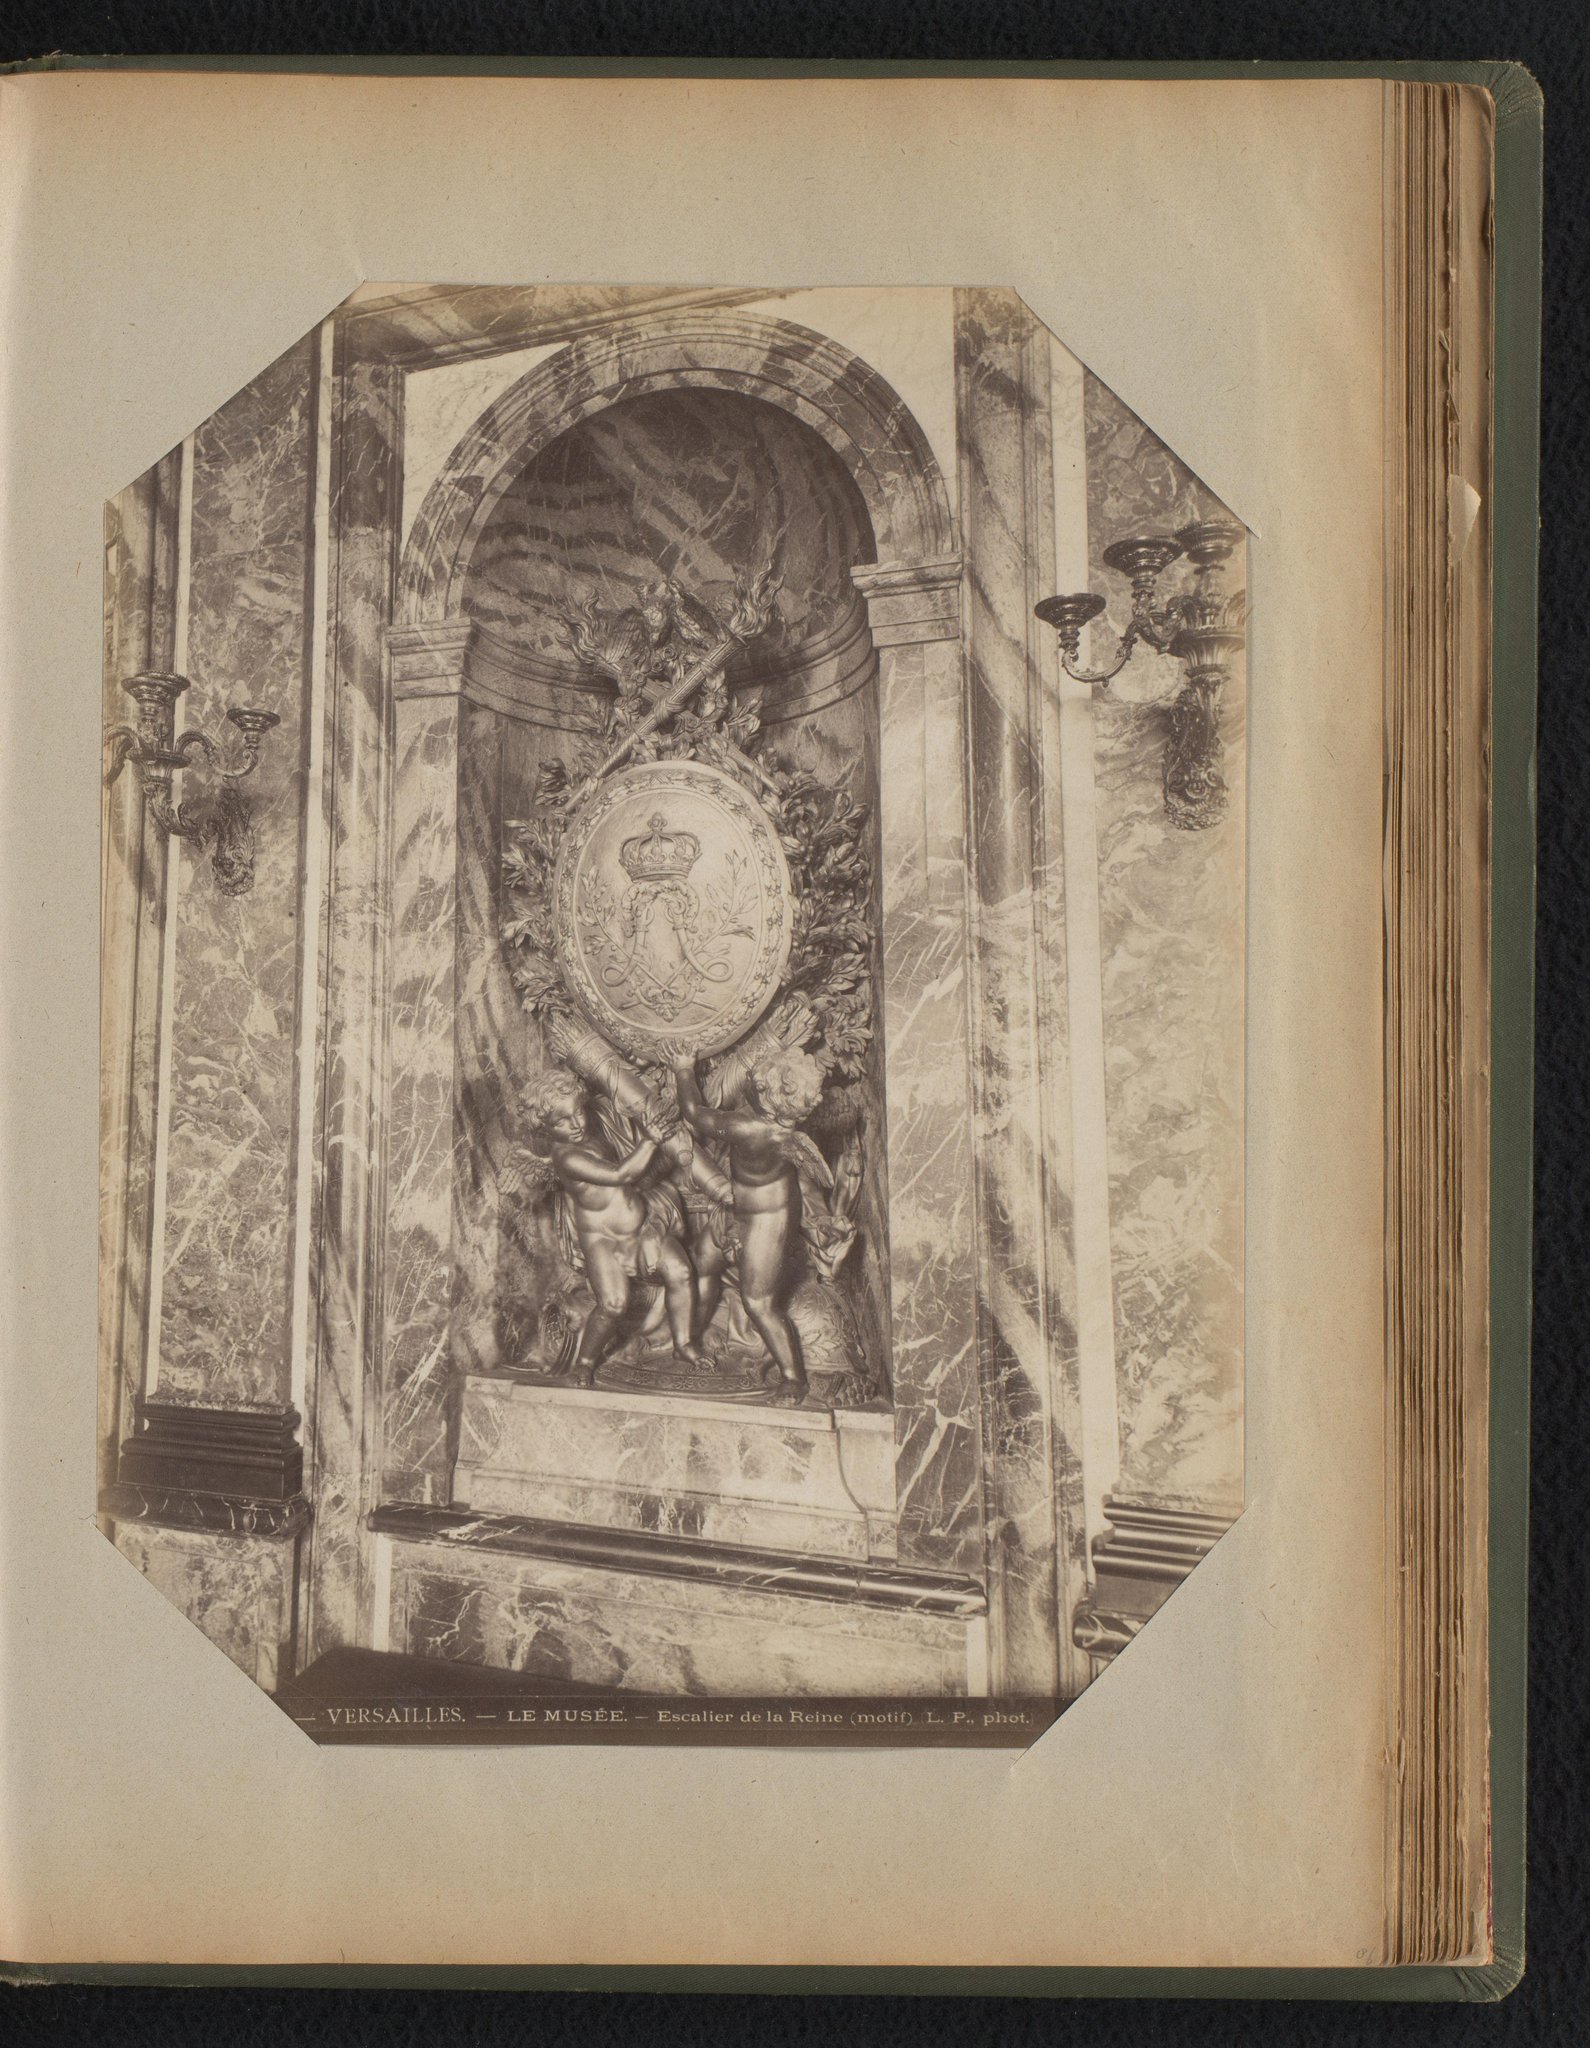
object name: photograph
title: 109. - Versailles. - Le musee - Escalier de la Reine (motif) (L.P.Phot).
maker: Anonymous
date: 1860-1900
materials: paper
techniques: albumen print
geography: france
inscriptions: annotation: ‘109. - Versailles. - Le musee - Escalier de la Reine (motif) (L.P.Phot).’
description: Onderdeel van een serie met betrekking tot het interieur van het paleis van Versailles met kroonluchters, deuren, portalen en meubelstukken.